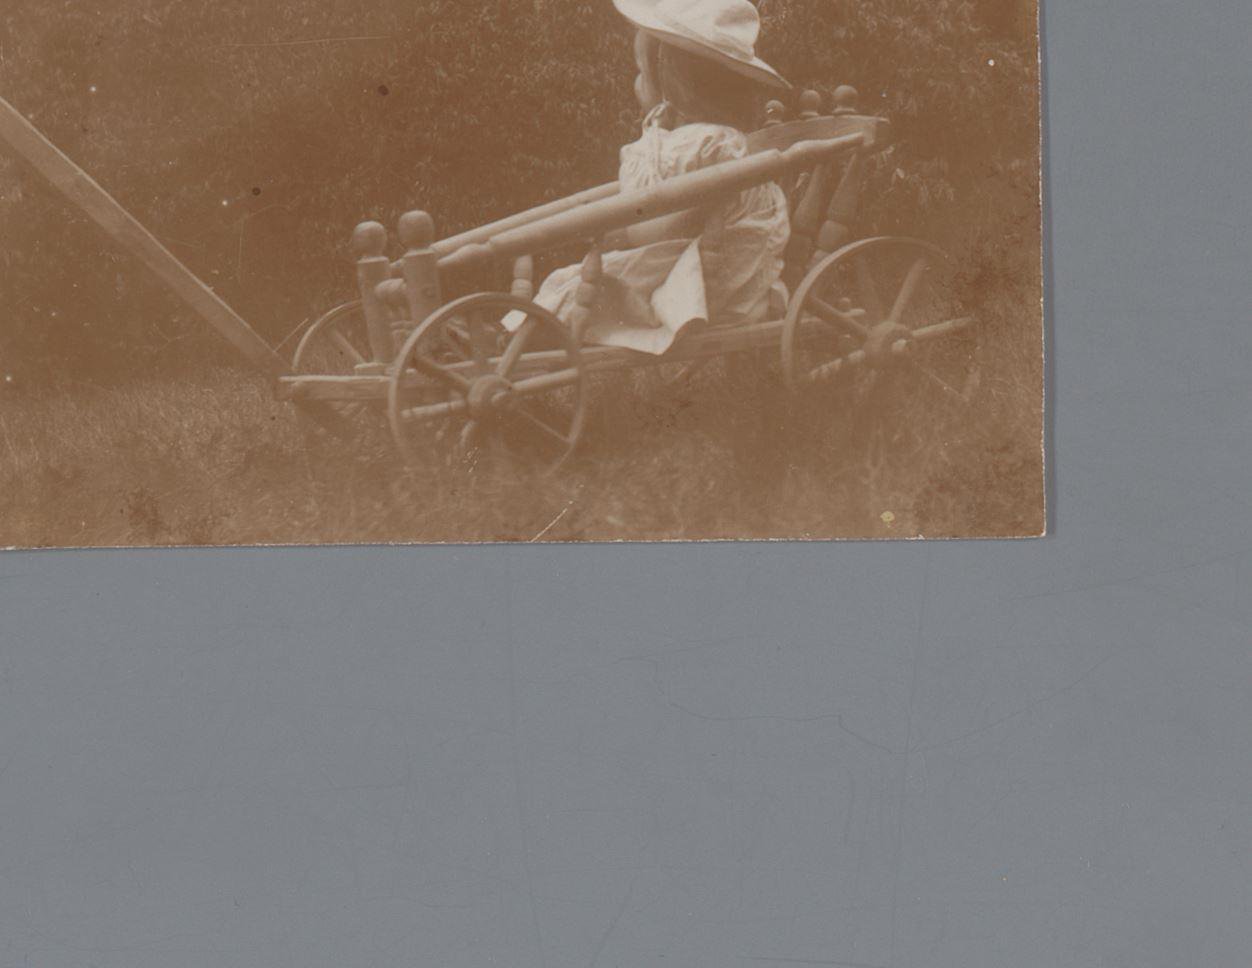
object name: photograph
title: Portret van een onbekend meisje in een kar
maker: johannes diderik van der waals (1873-1971)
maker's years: 1873-1971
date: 1904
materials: photographic support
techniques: collodion silver print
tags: hand-cart, child, historical persons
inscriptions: annotation: ‘JD vd Waals’